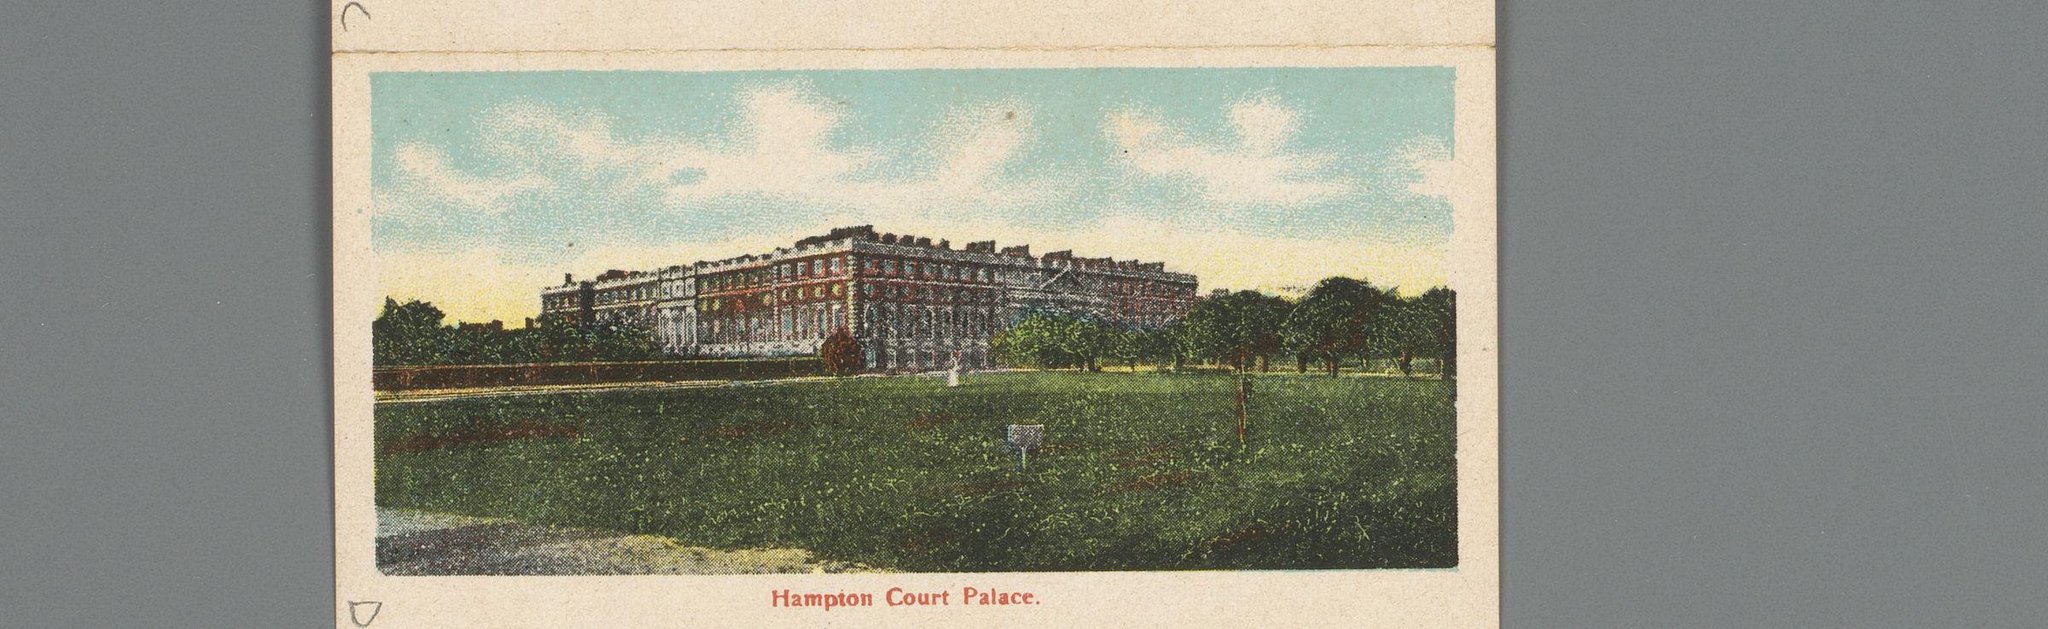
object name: photomechanical print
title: Gezicht op Hampton Court Palace, Londen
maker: Anonymous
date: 1888-1914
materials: paper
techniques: autotype, chromophotolithography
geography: london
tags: palace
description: Deze prent maakt deel uit van een album.